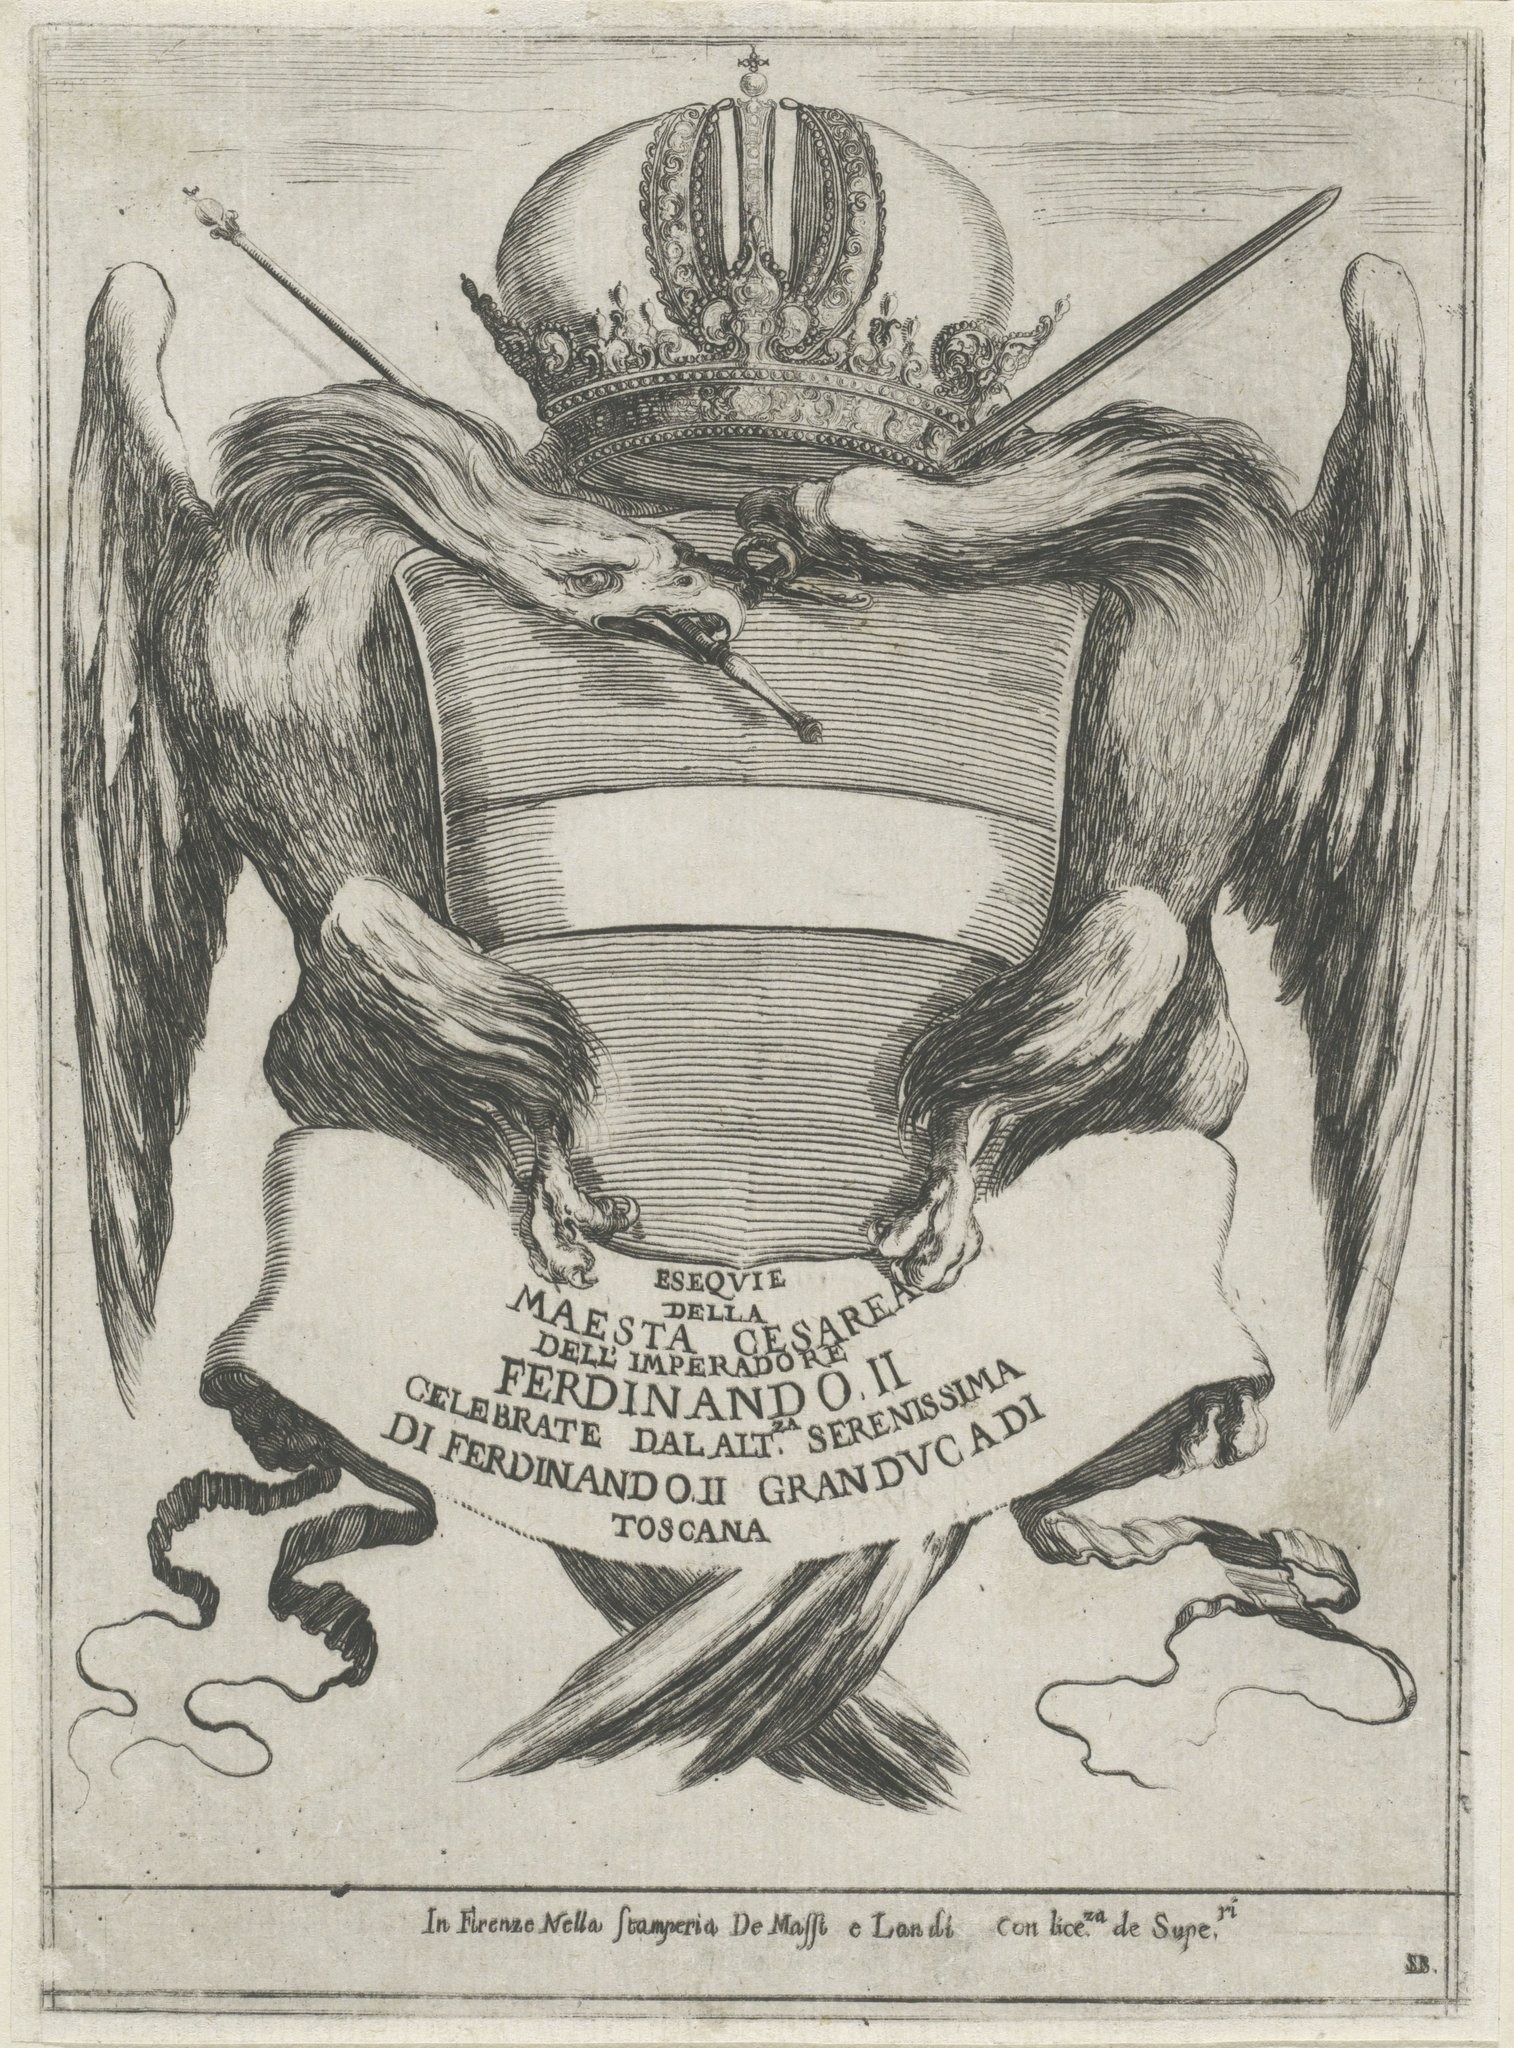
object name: print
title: Gekroond wapenschild geflankeerd door twee adelaars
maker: stefano della bella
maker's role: draughtsman, print maker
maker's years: 1610-1664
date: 1620-1664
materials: paper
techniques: etching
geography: italy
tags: vienna, ferdinand ii (duits keizer), coat of arms (symbol of sovereignty)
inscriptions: collector's mark: Lugt 240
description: Gekroond wapenschild geflankeerd door twee adelaars met een tekst ter verheerlijking van Keizer Ferdinand II.